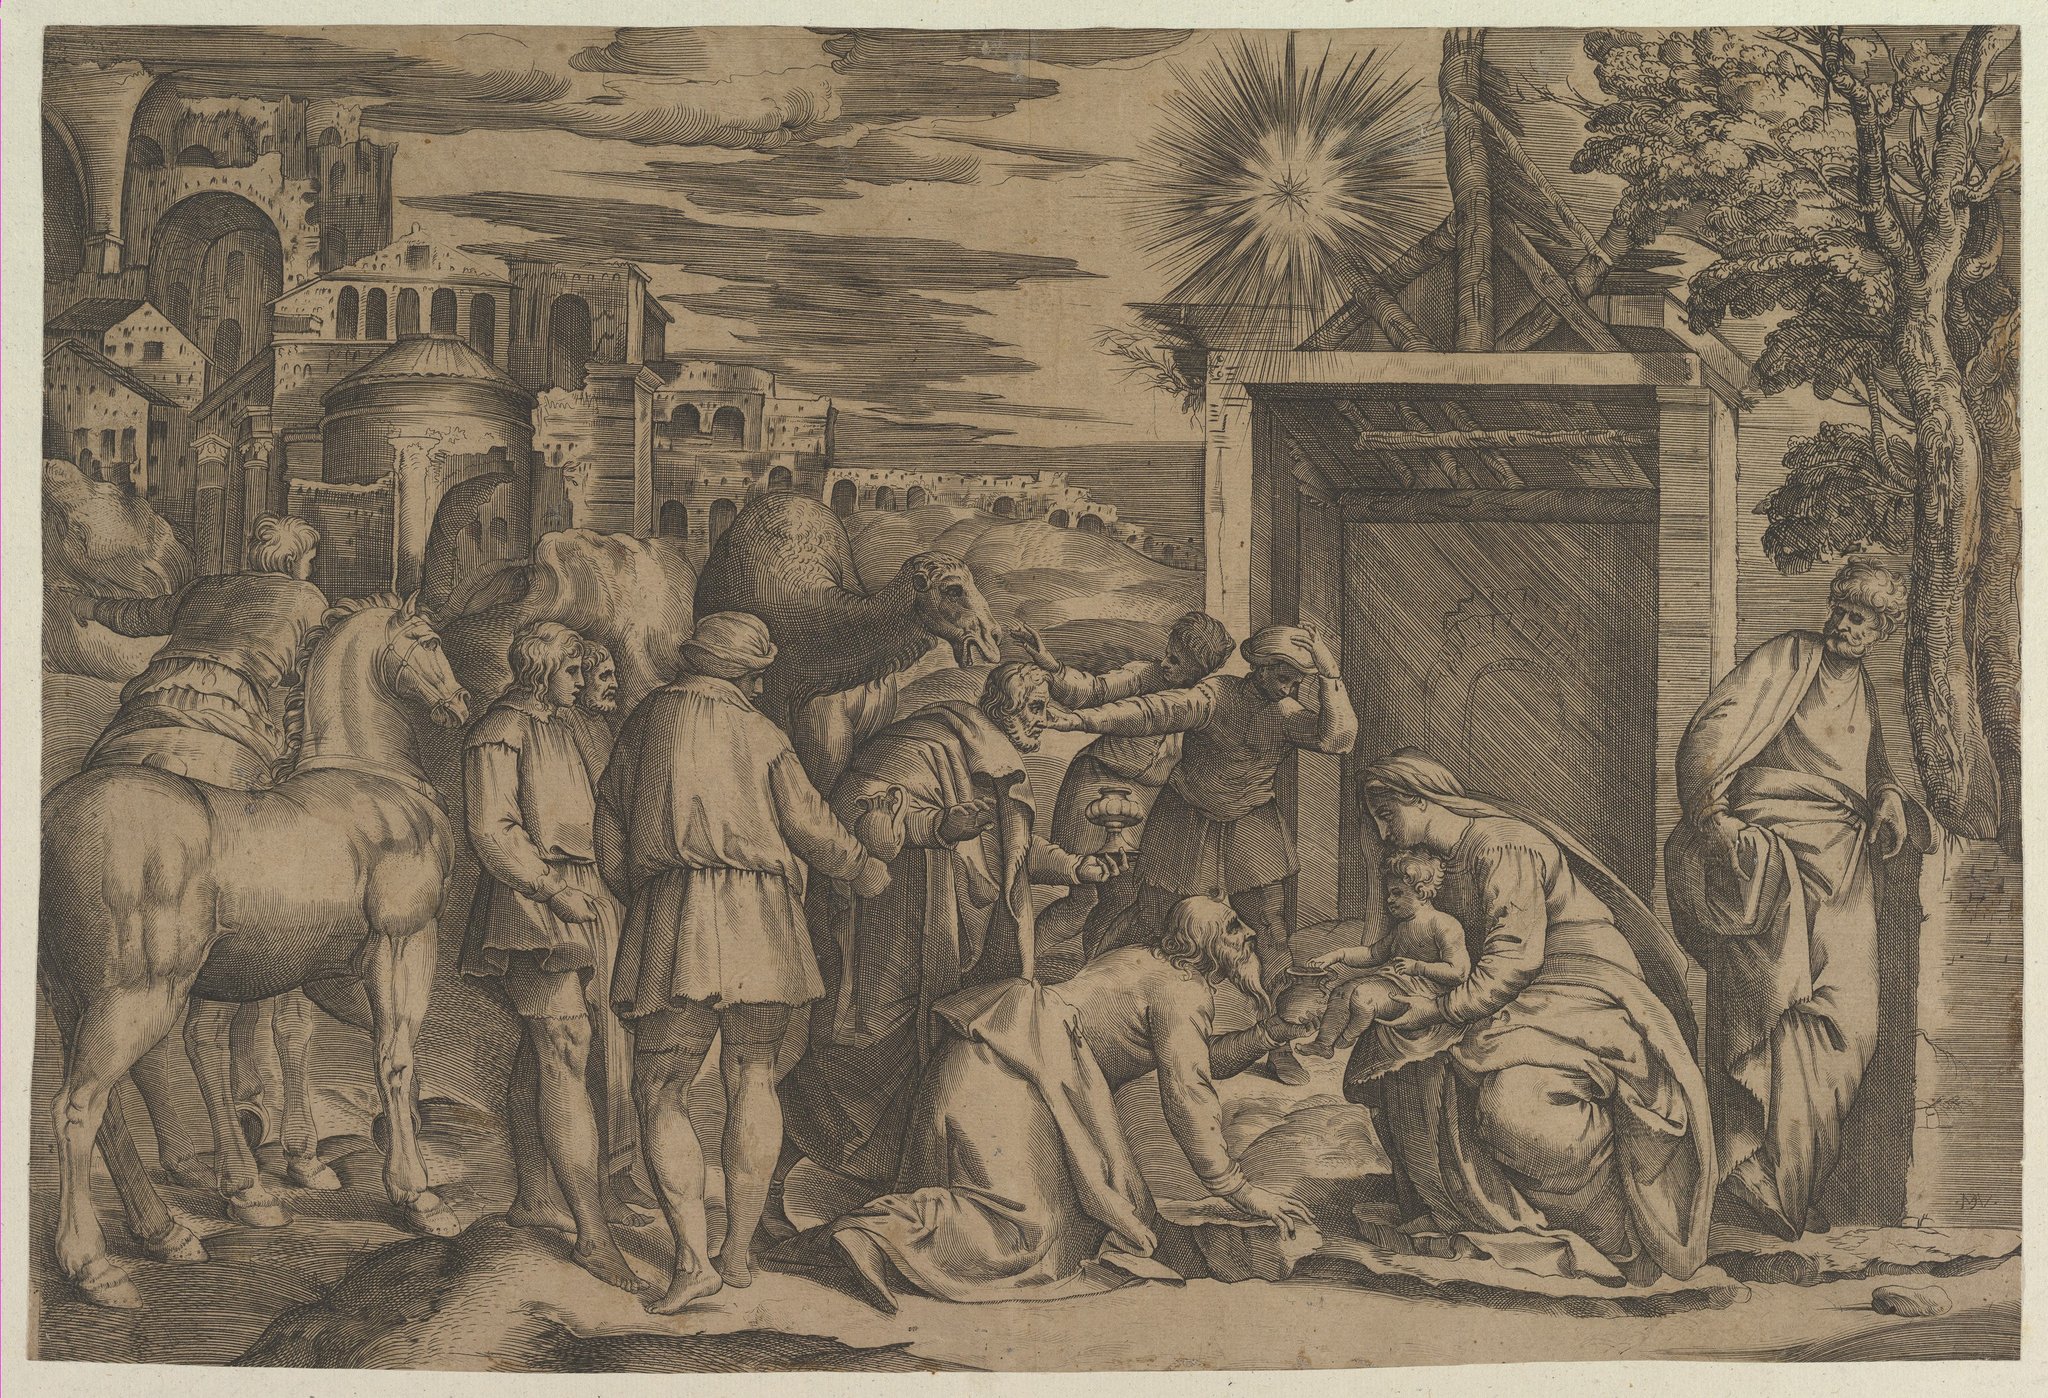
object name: print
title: The Adoration of the Magi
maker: battista franco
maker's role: artist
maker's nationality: italian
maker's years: 1510-1561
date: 1530-1561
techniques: engraving, etching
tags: buildings,men,camels,horses,adoration of the magi